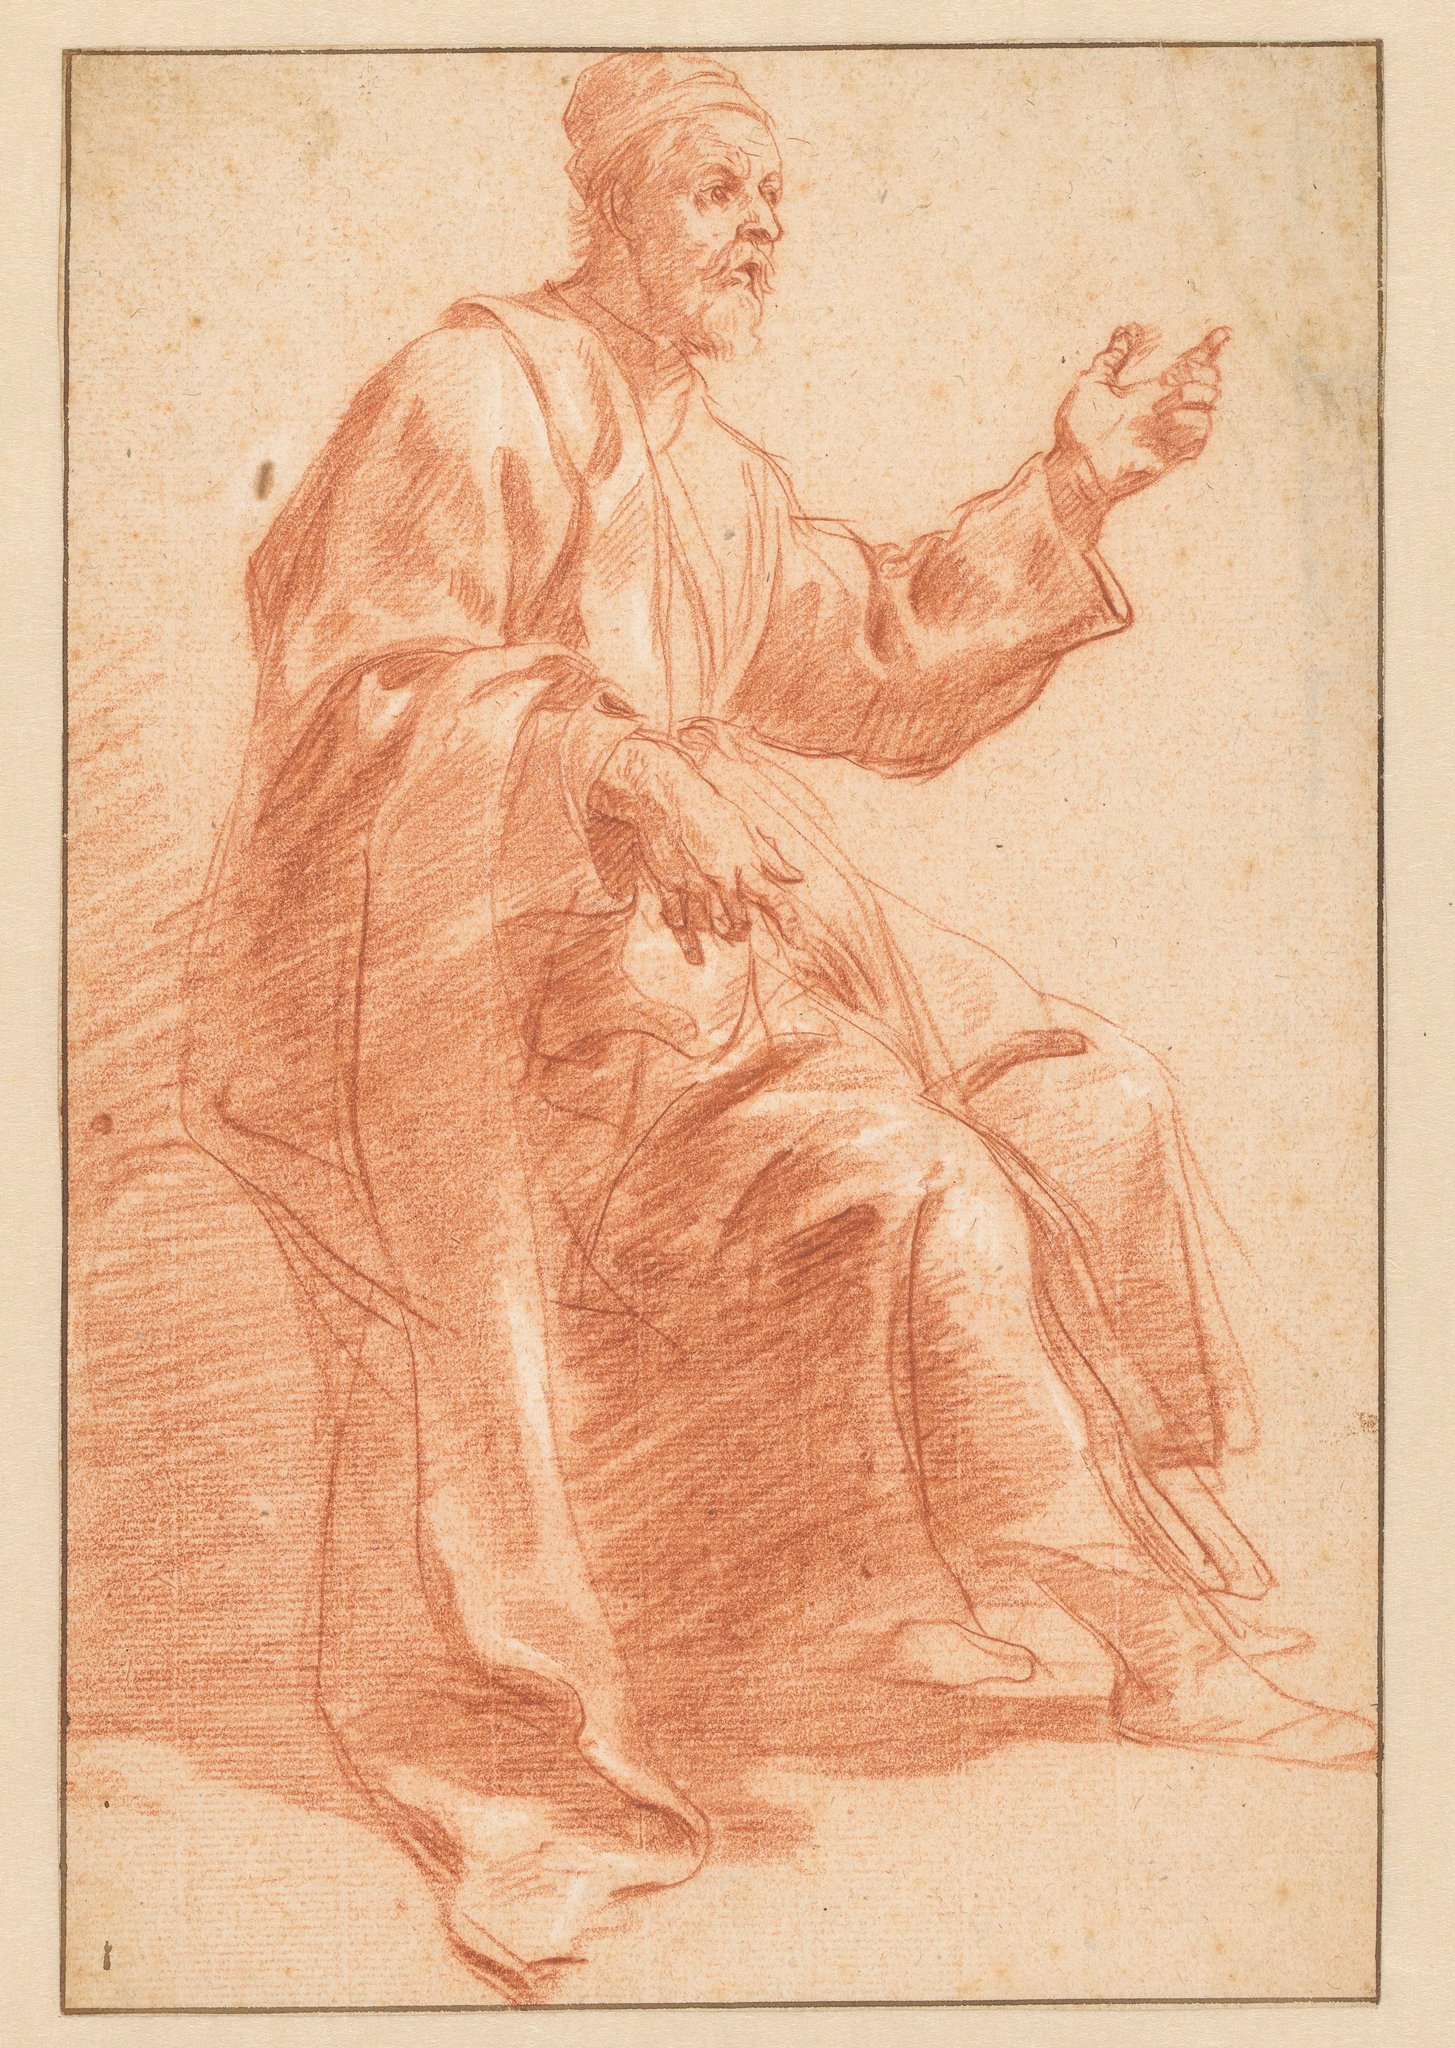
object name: drawing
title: Zittende oude man met opgeheven linkerhand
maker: jan van den bergh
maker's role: publisher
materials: chalk, paint, paper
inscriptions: signature and date: ‘Alkma.../28.’